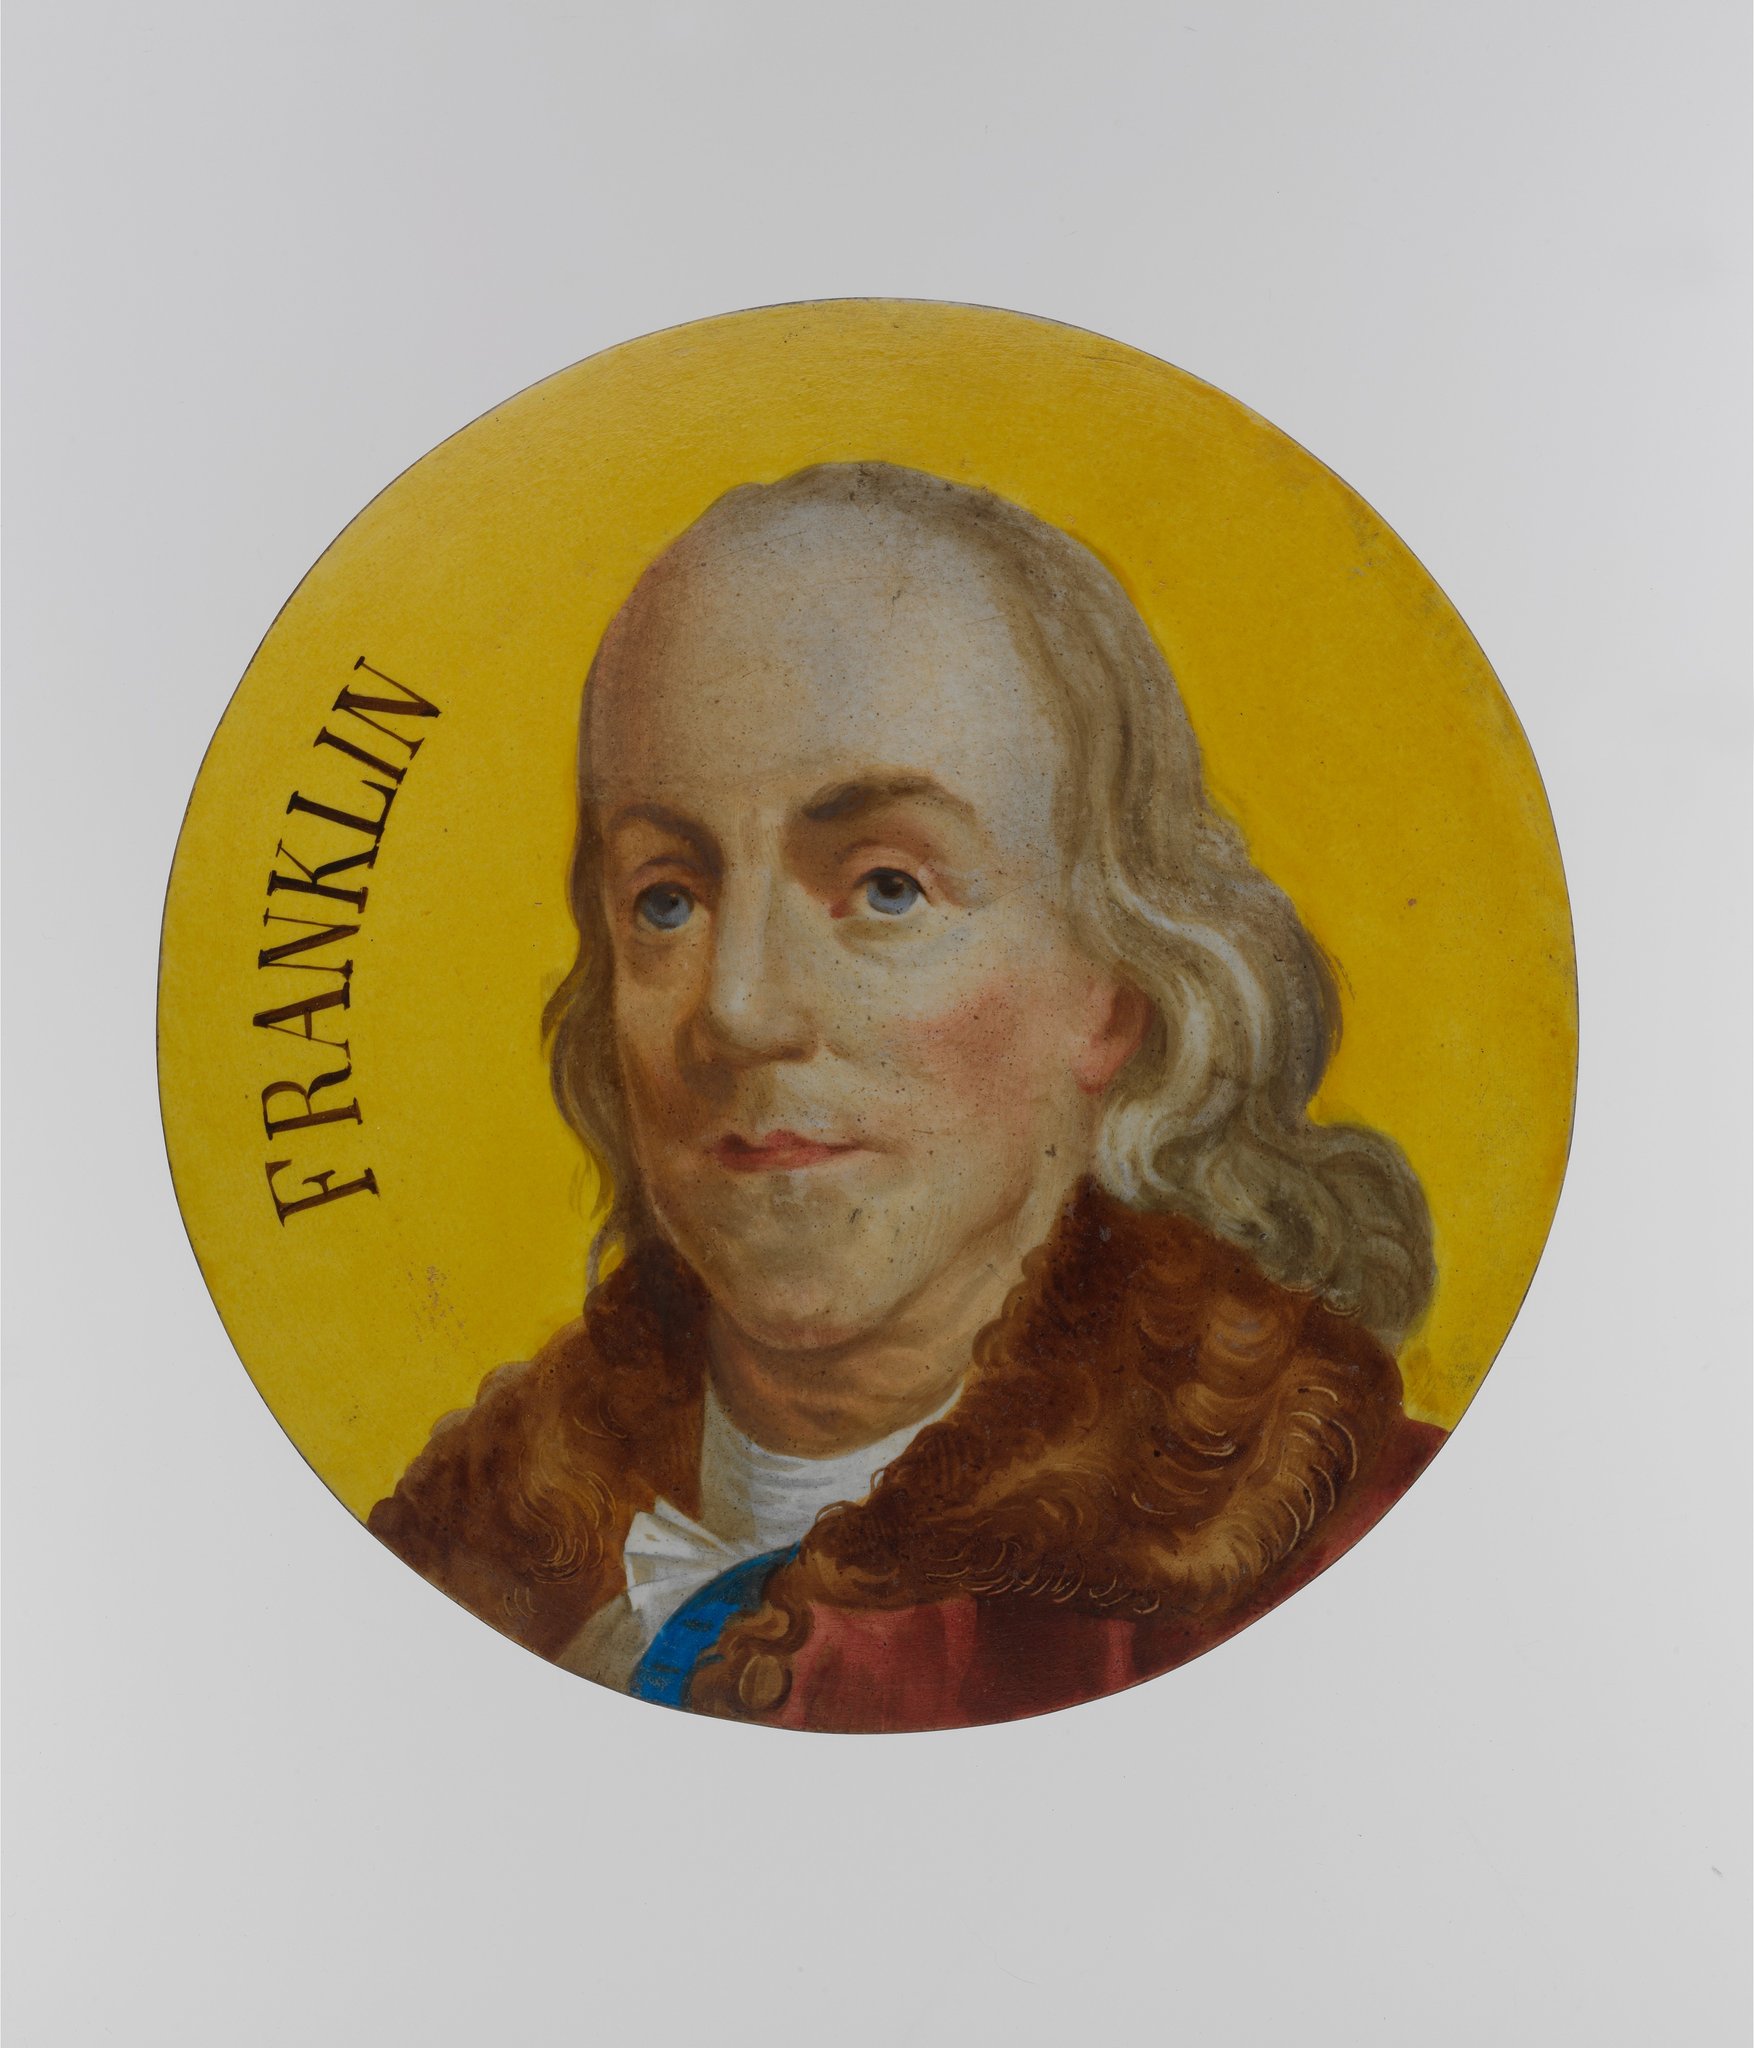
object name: plate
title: Benjamin Franklin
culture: french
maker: joseph siffred duplessis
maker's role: artist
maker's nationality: french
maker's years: 1725-1802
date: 1800-1883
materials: faience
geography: france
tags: benjamin franklin,men,portraits